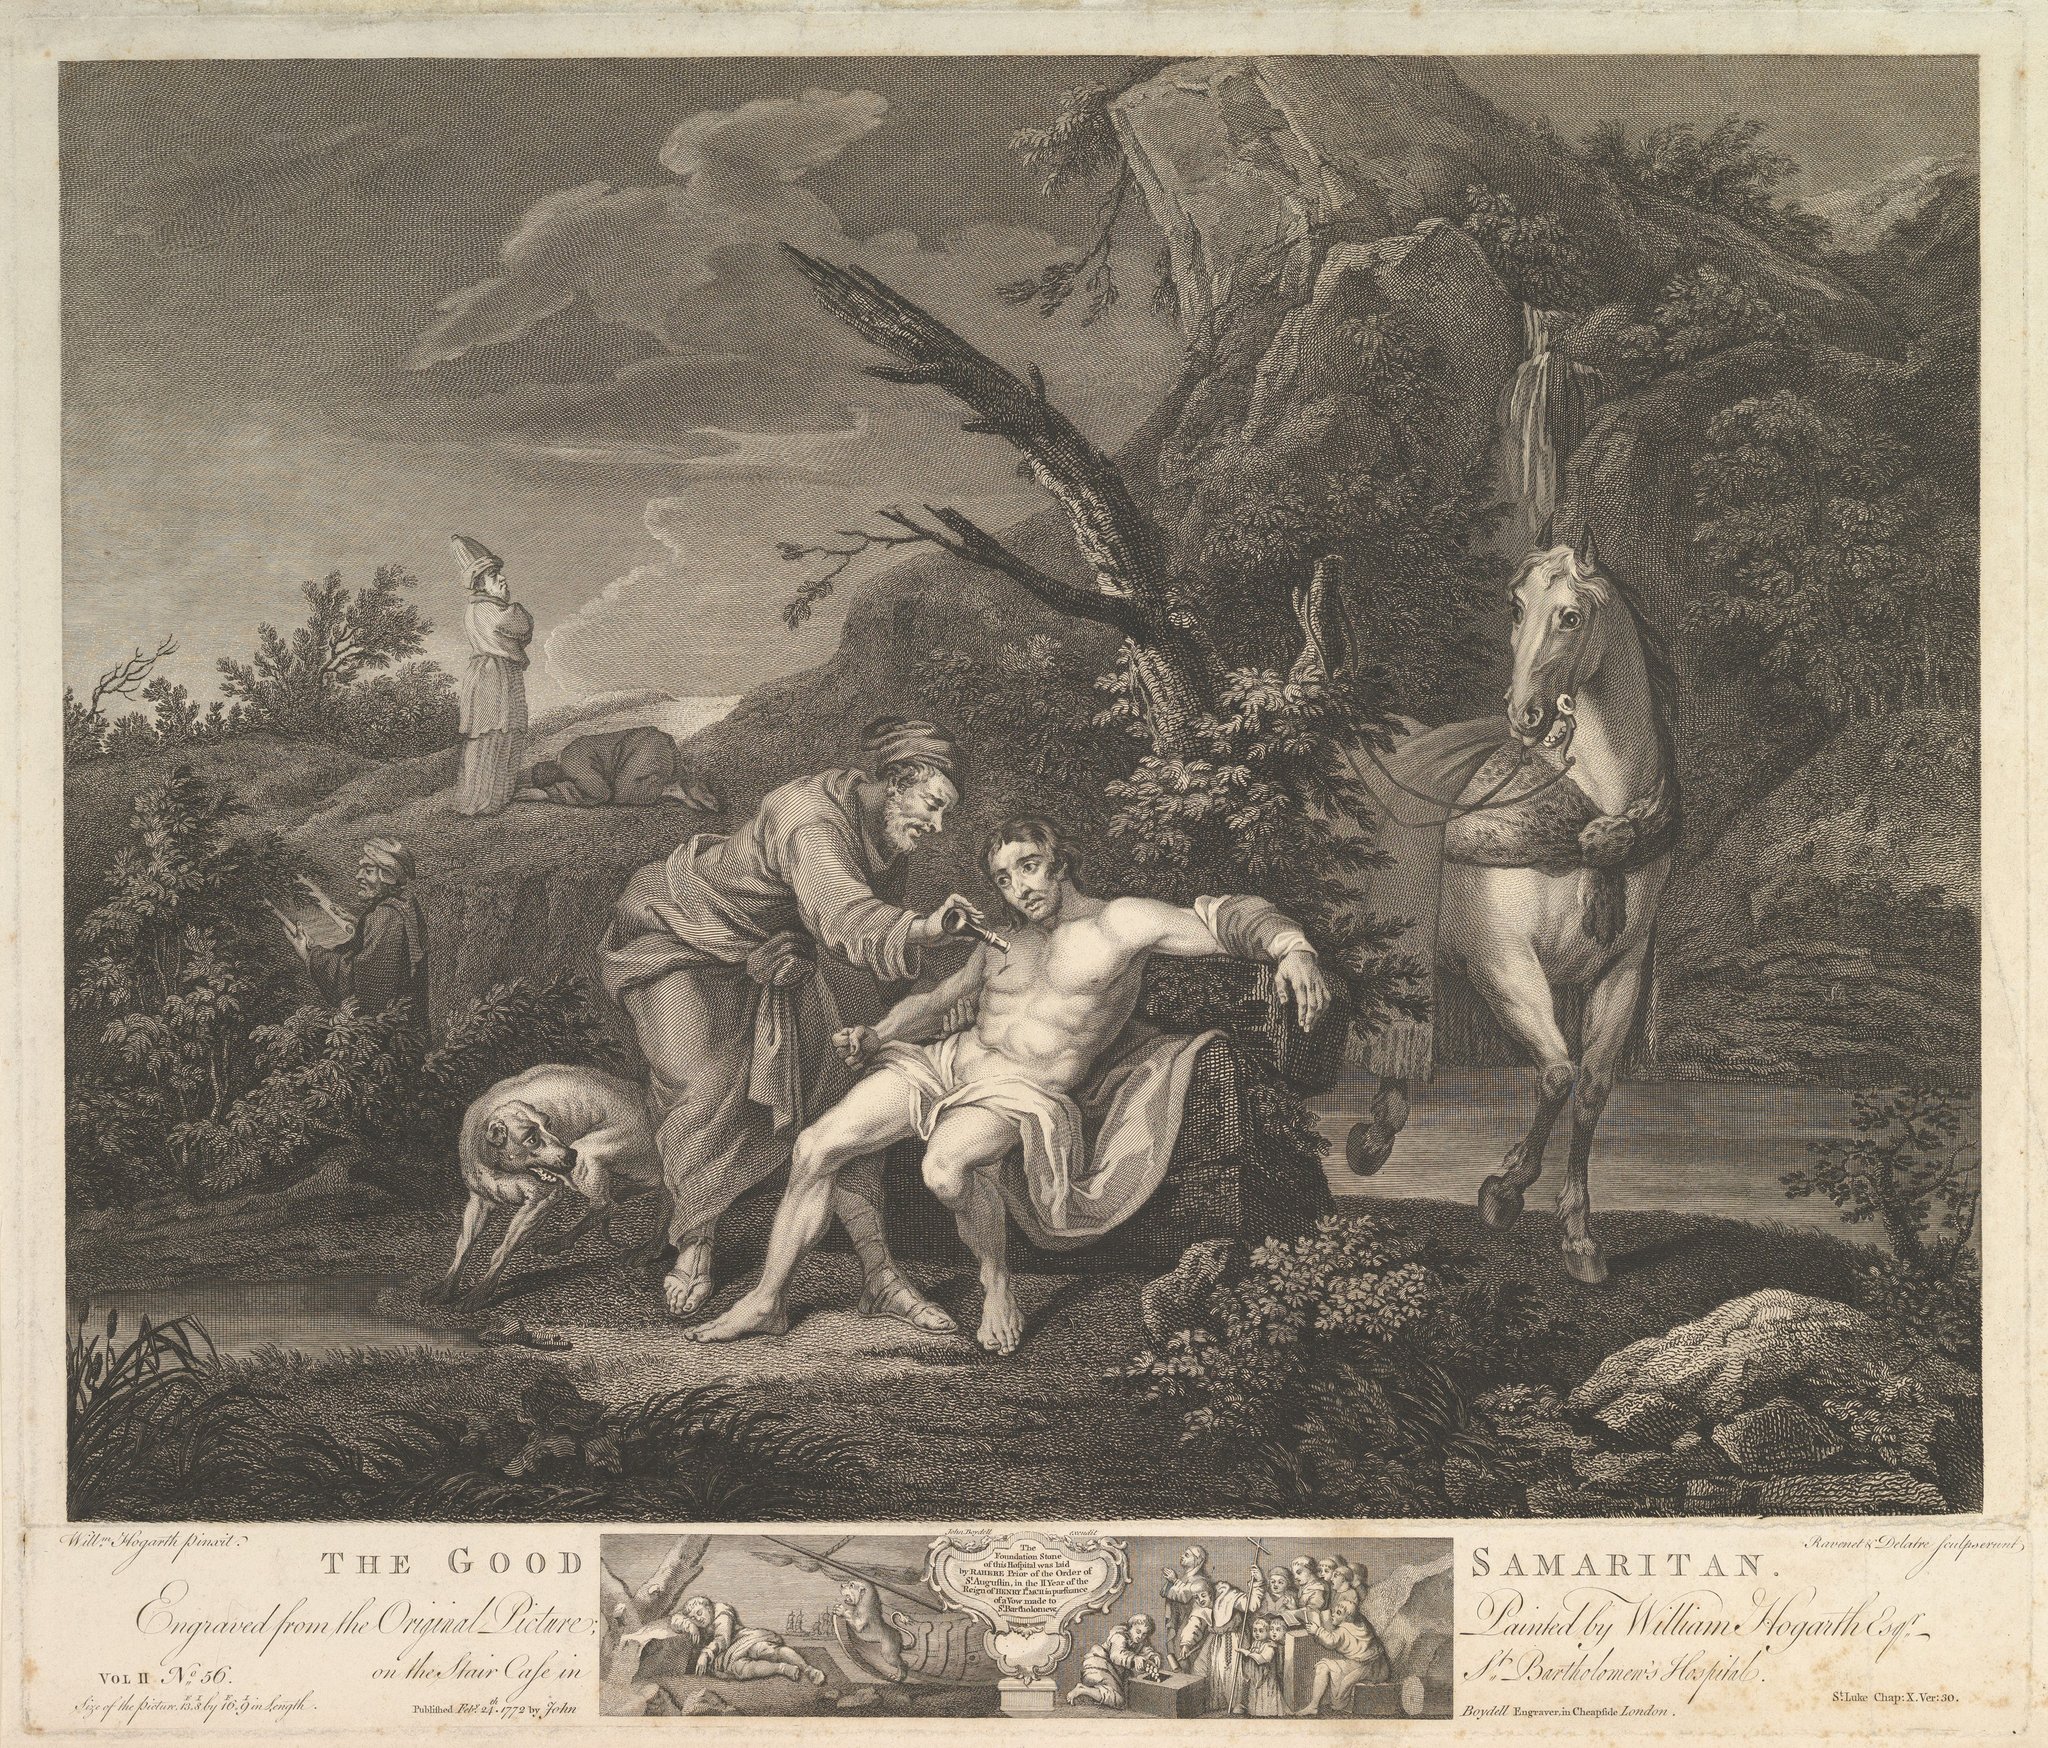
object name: print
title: The Good Samaritan (St. Luke, Chap. 10, verse 30)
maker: william hogarth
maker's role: artist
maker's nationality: british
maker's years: 1697-1764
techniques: engraving, etching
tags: men,dogs,horses,saints